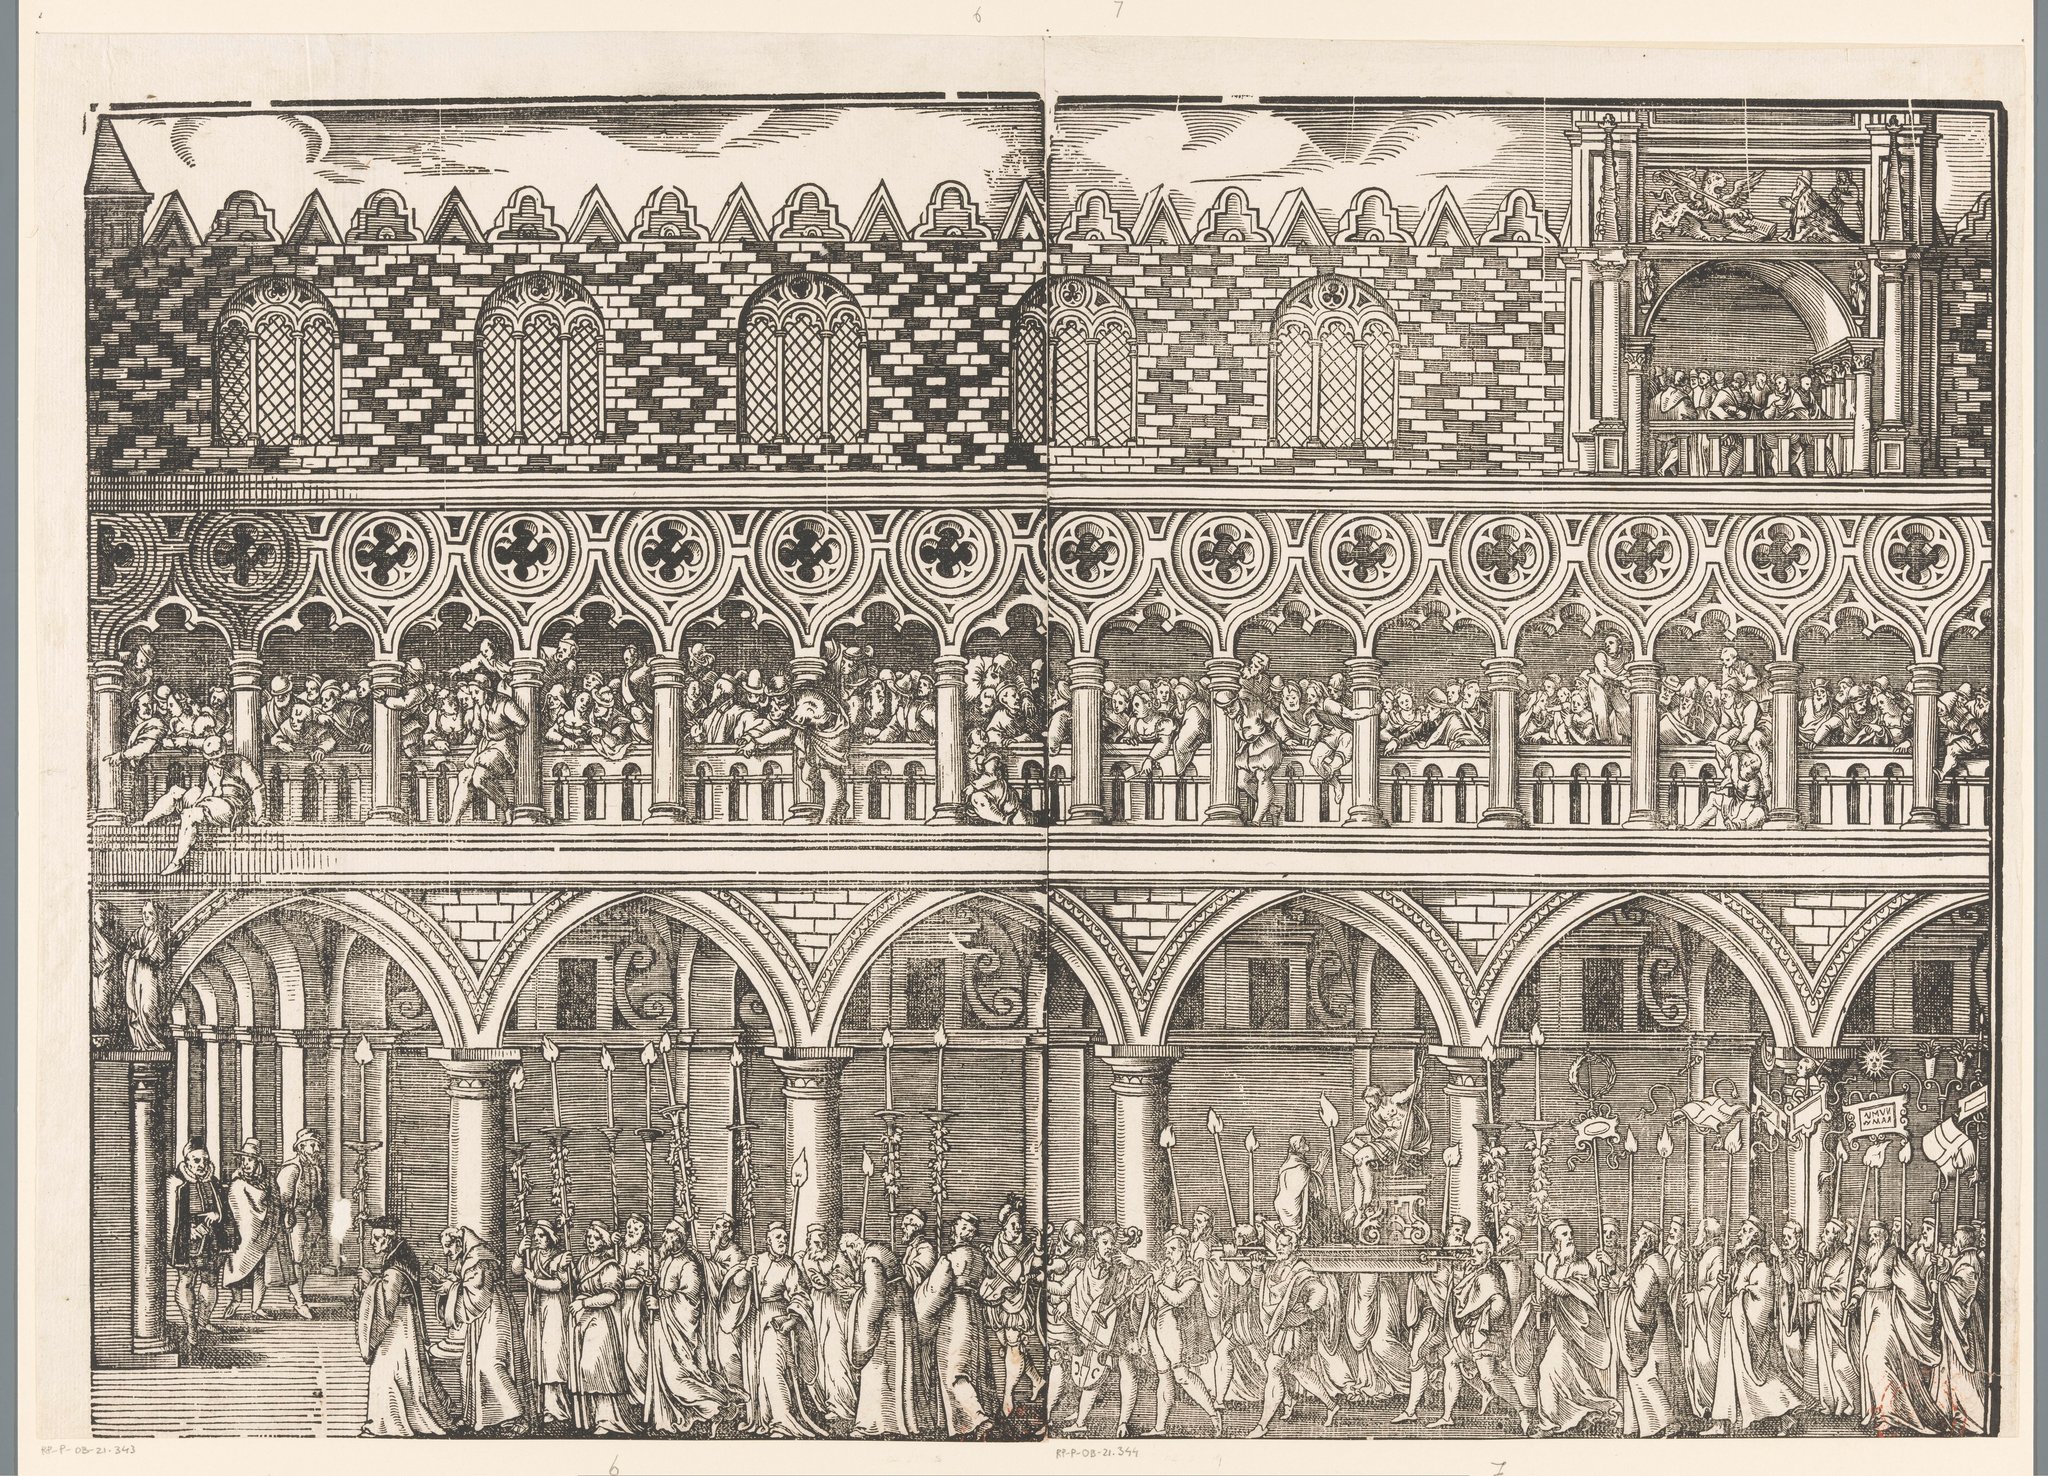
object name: print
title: Festa della Sensa (zevende gedeelte)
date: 1679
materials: paper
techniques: woodcut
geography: nuremberg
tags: city-view in general; 'veduta', lion (possibly with book) ~ symbol of st. mark, string instruments (bowed) - cc - out of doors, wind instruments - cc - out of doors, procession ~ christian religion, gondola, venice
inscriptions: collector's mark: Lugt 240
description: Zevende gedeelte van een grote voorstelling van de Festa della Sensa. De voorstelling is gedrukt van veertien blokken, de titel van vijf blokken en het onderschrift bestaat uit vijf delen van elk drie kolommen Duits tekst. De veertien blokken die samen de voorstelling vormen zijn in de titels met de klok mee vanaf linksboven genummerd. In de collectie Rijksmuseum bevinden zich twee complete exemplaren inclusief titel en onderschrift. Omdat niet alle delen van de titel en het onderschrift op afzonderlijke bladen zijn gedrukt, is dit exemplaar niet virtueel samengevoegd omwille van een betere presentatie. Zie voor het andere exemplaar: RP-P-2017-6073.